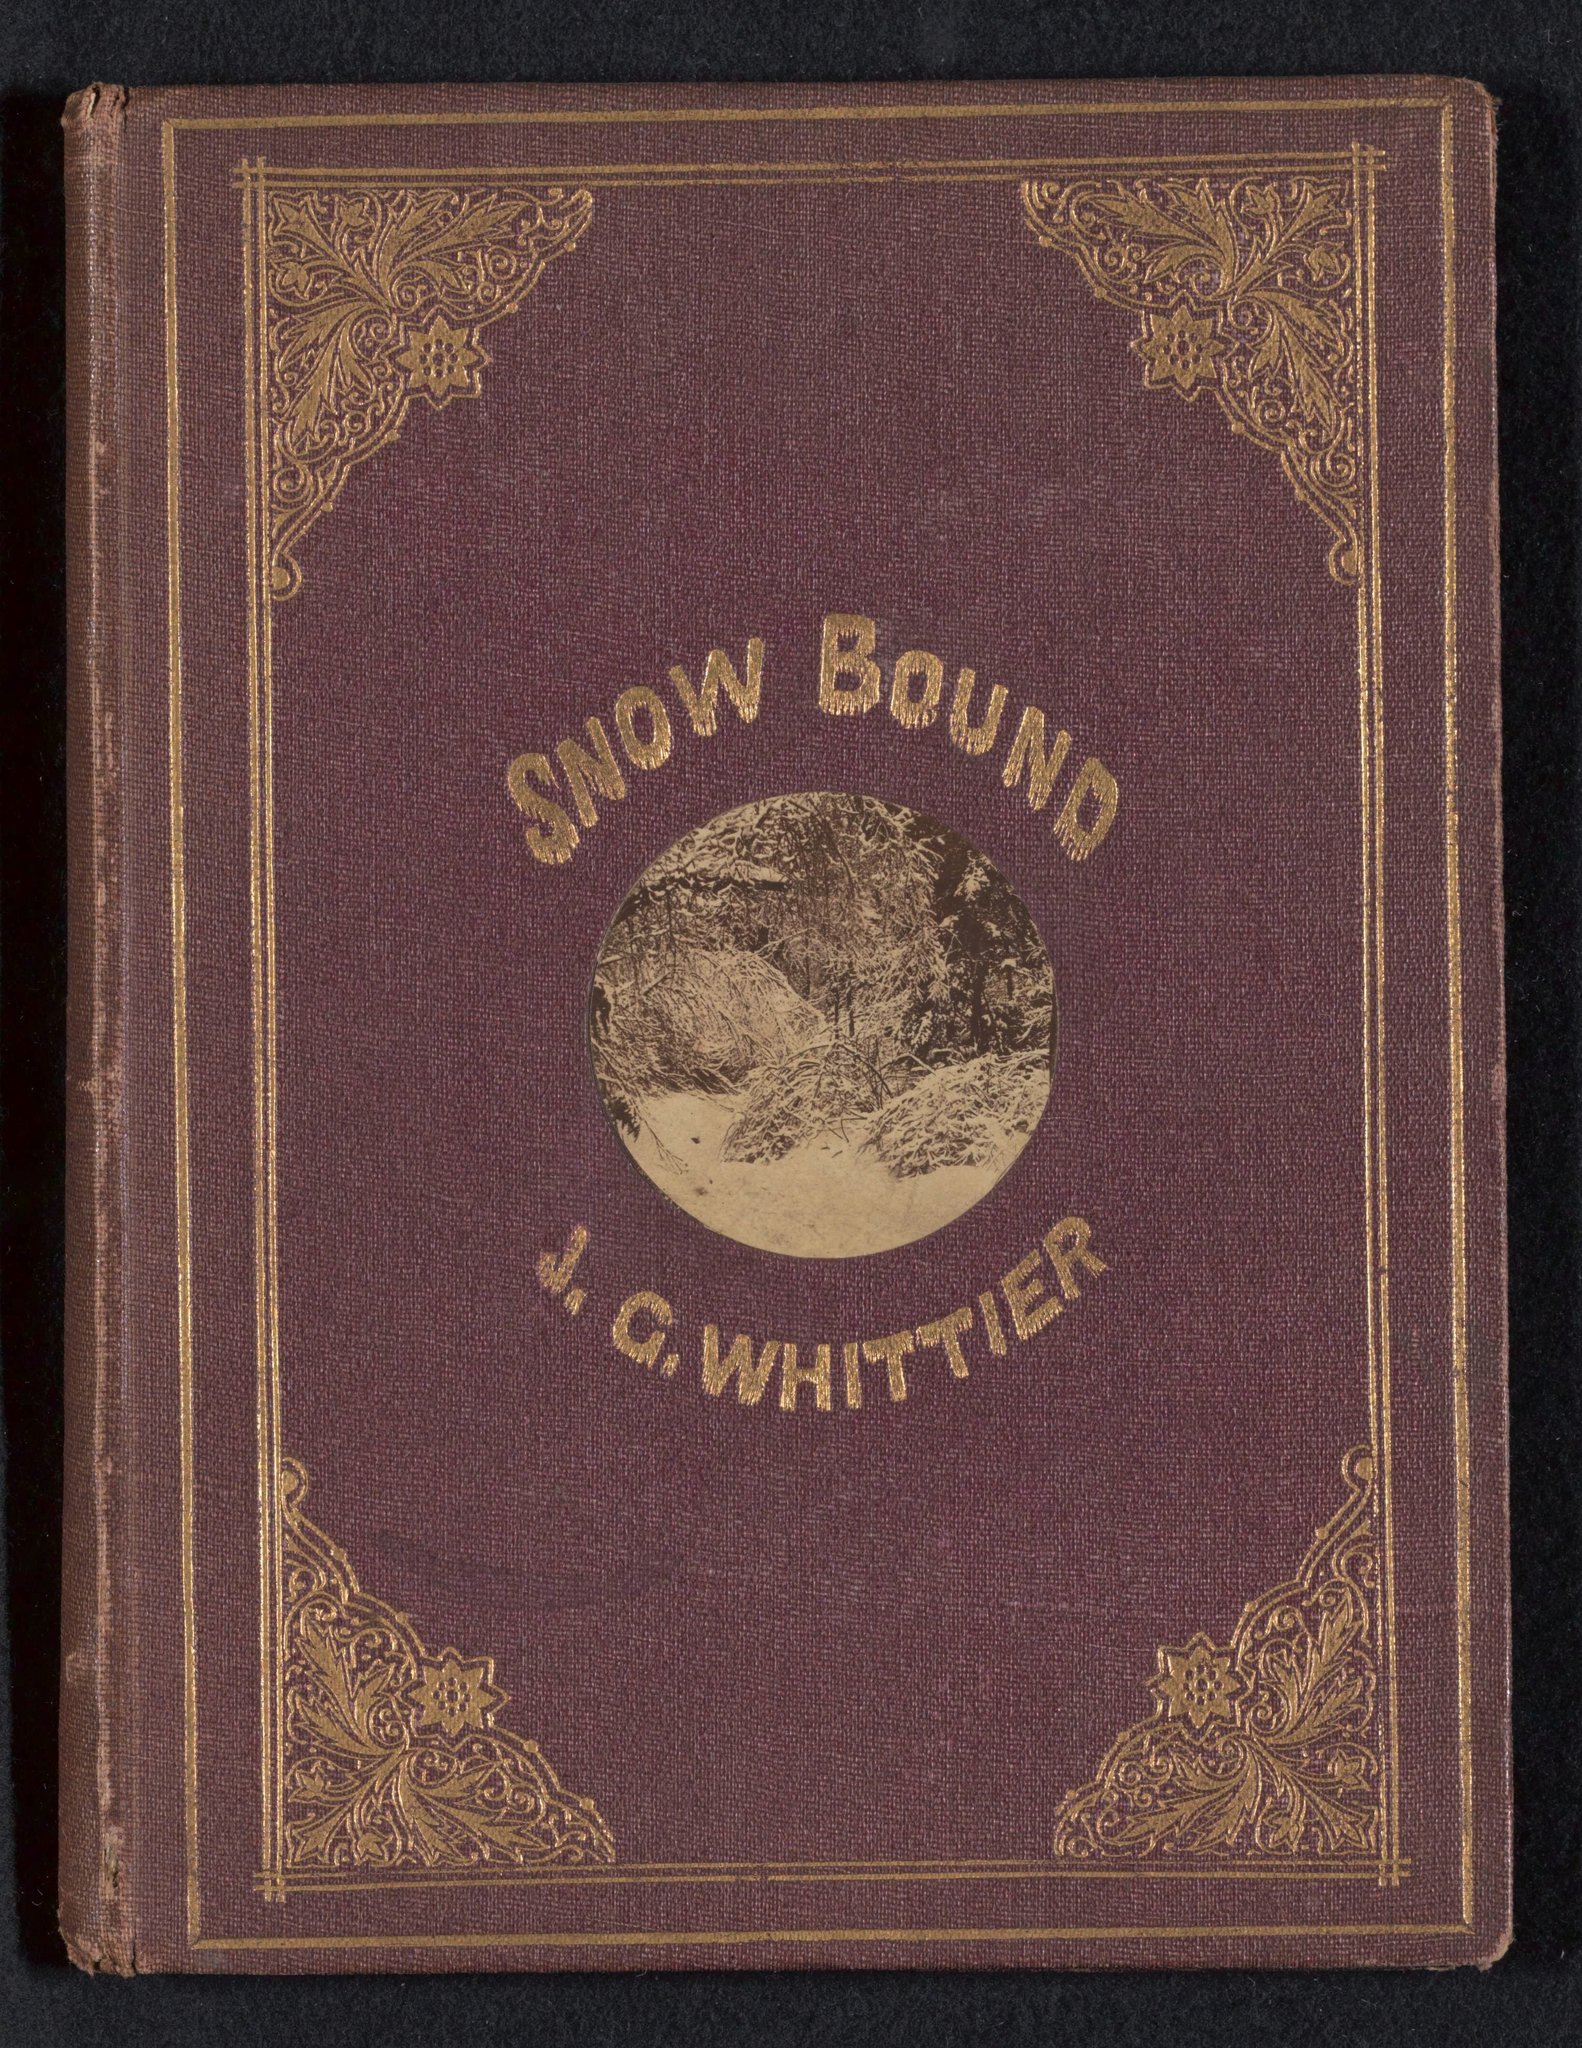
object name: photograph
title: Sneeuwlandschap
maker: Anonymous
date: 1862-1867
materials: photographic support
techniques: albumen print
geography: united states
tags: winter landscape; landscape symbolizing winter (the four seasons of the year), snow